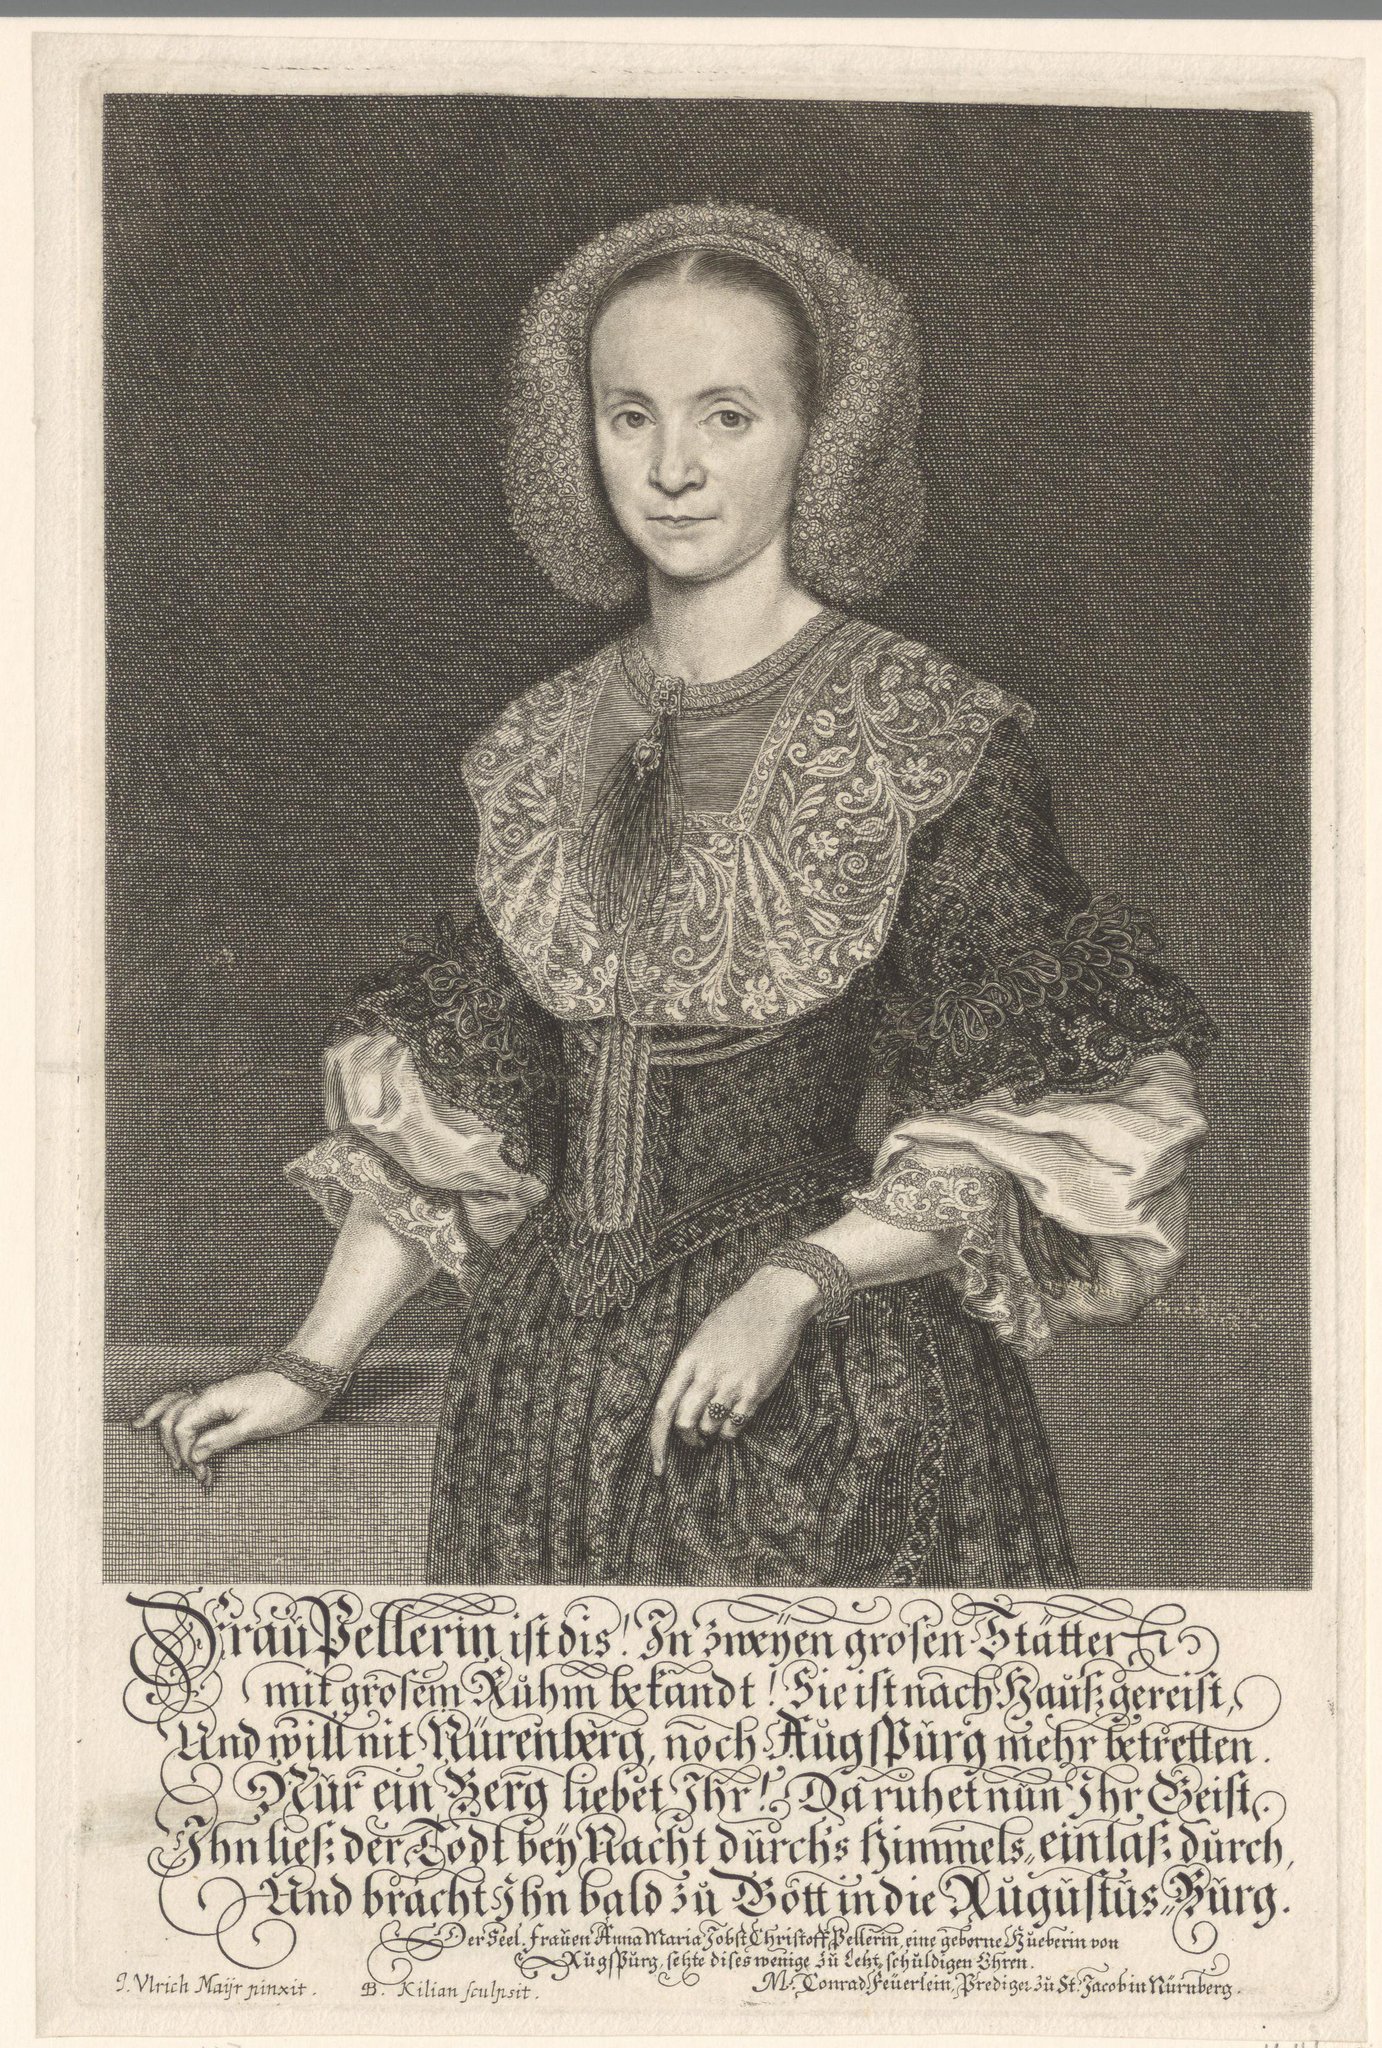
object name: print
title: Portret van Anna Maria Peller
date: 1671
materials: paper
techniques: engraving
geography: nuremberg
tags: historical persons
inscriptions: collector's mark: Lugt 2228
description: Geportretteerde ook bekend met haar meisjesnaam Anna Maria Huber en later als Anna Maria Peller von Schoppferhof zu Muggendorf. Tekst in het Duits in de marge.